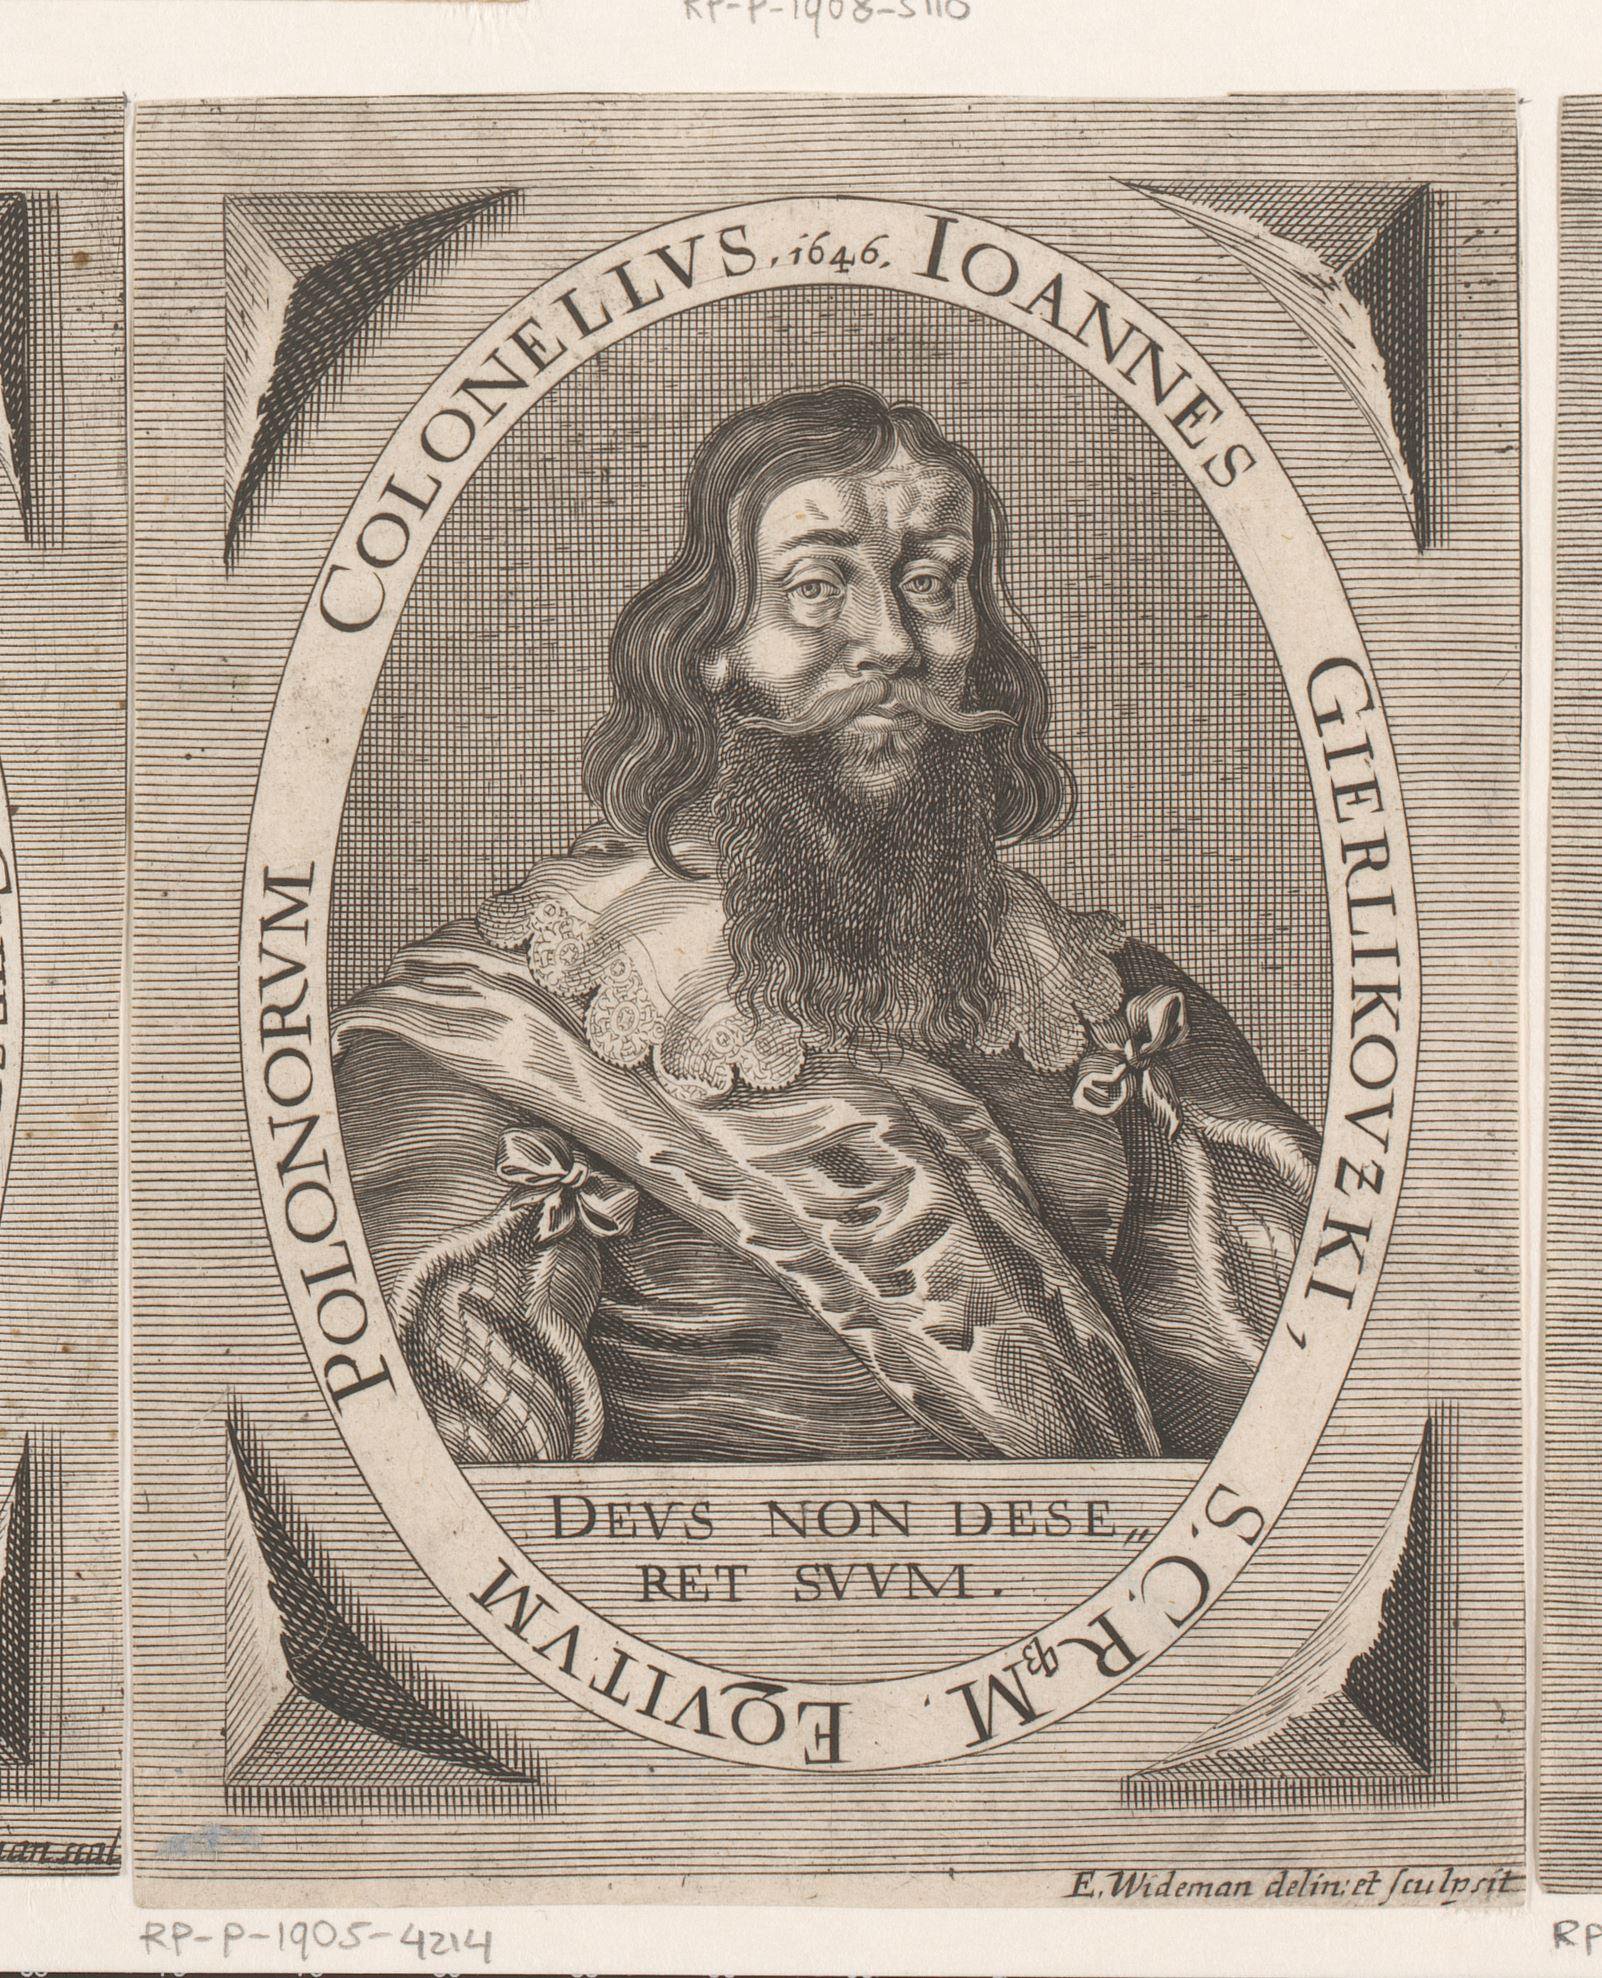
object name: print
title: Portret van Jan Gierlikowski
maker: elias widemann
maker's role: print maker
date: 1646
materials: paper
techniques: engraving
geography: vienna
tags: historical persons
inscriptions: collector's mark: Lugt 2228